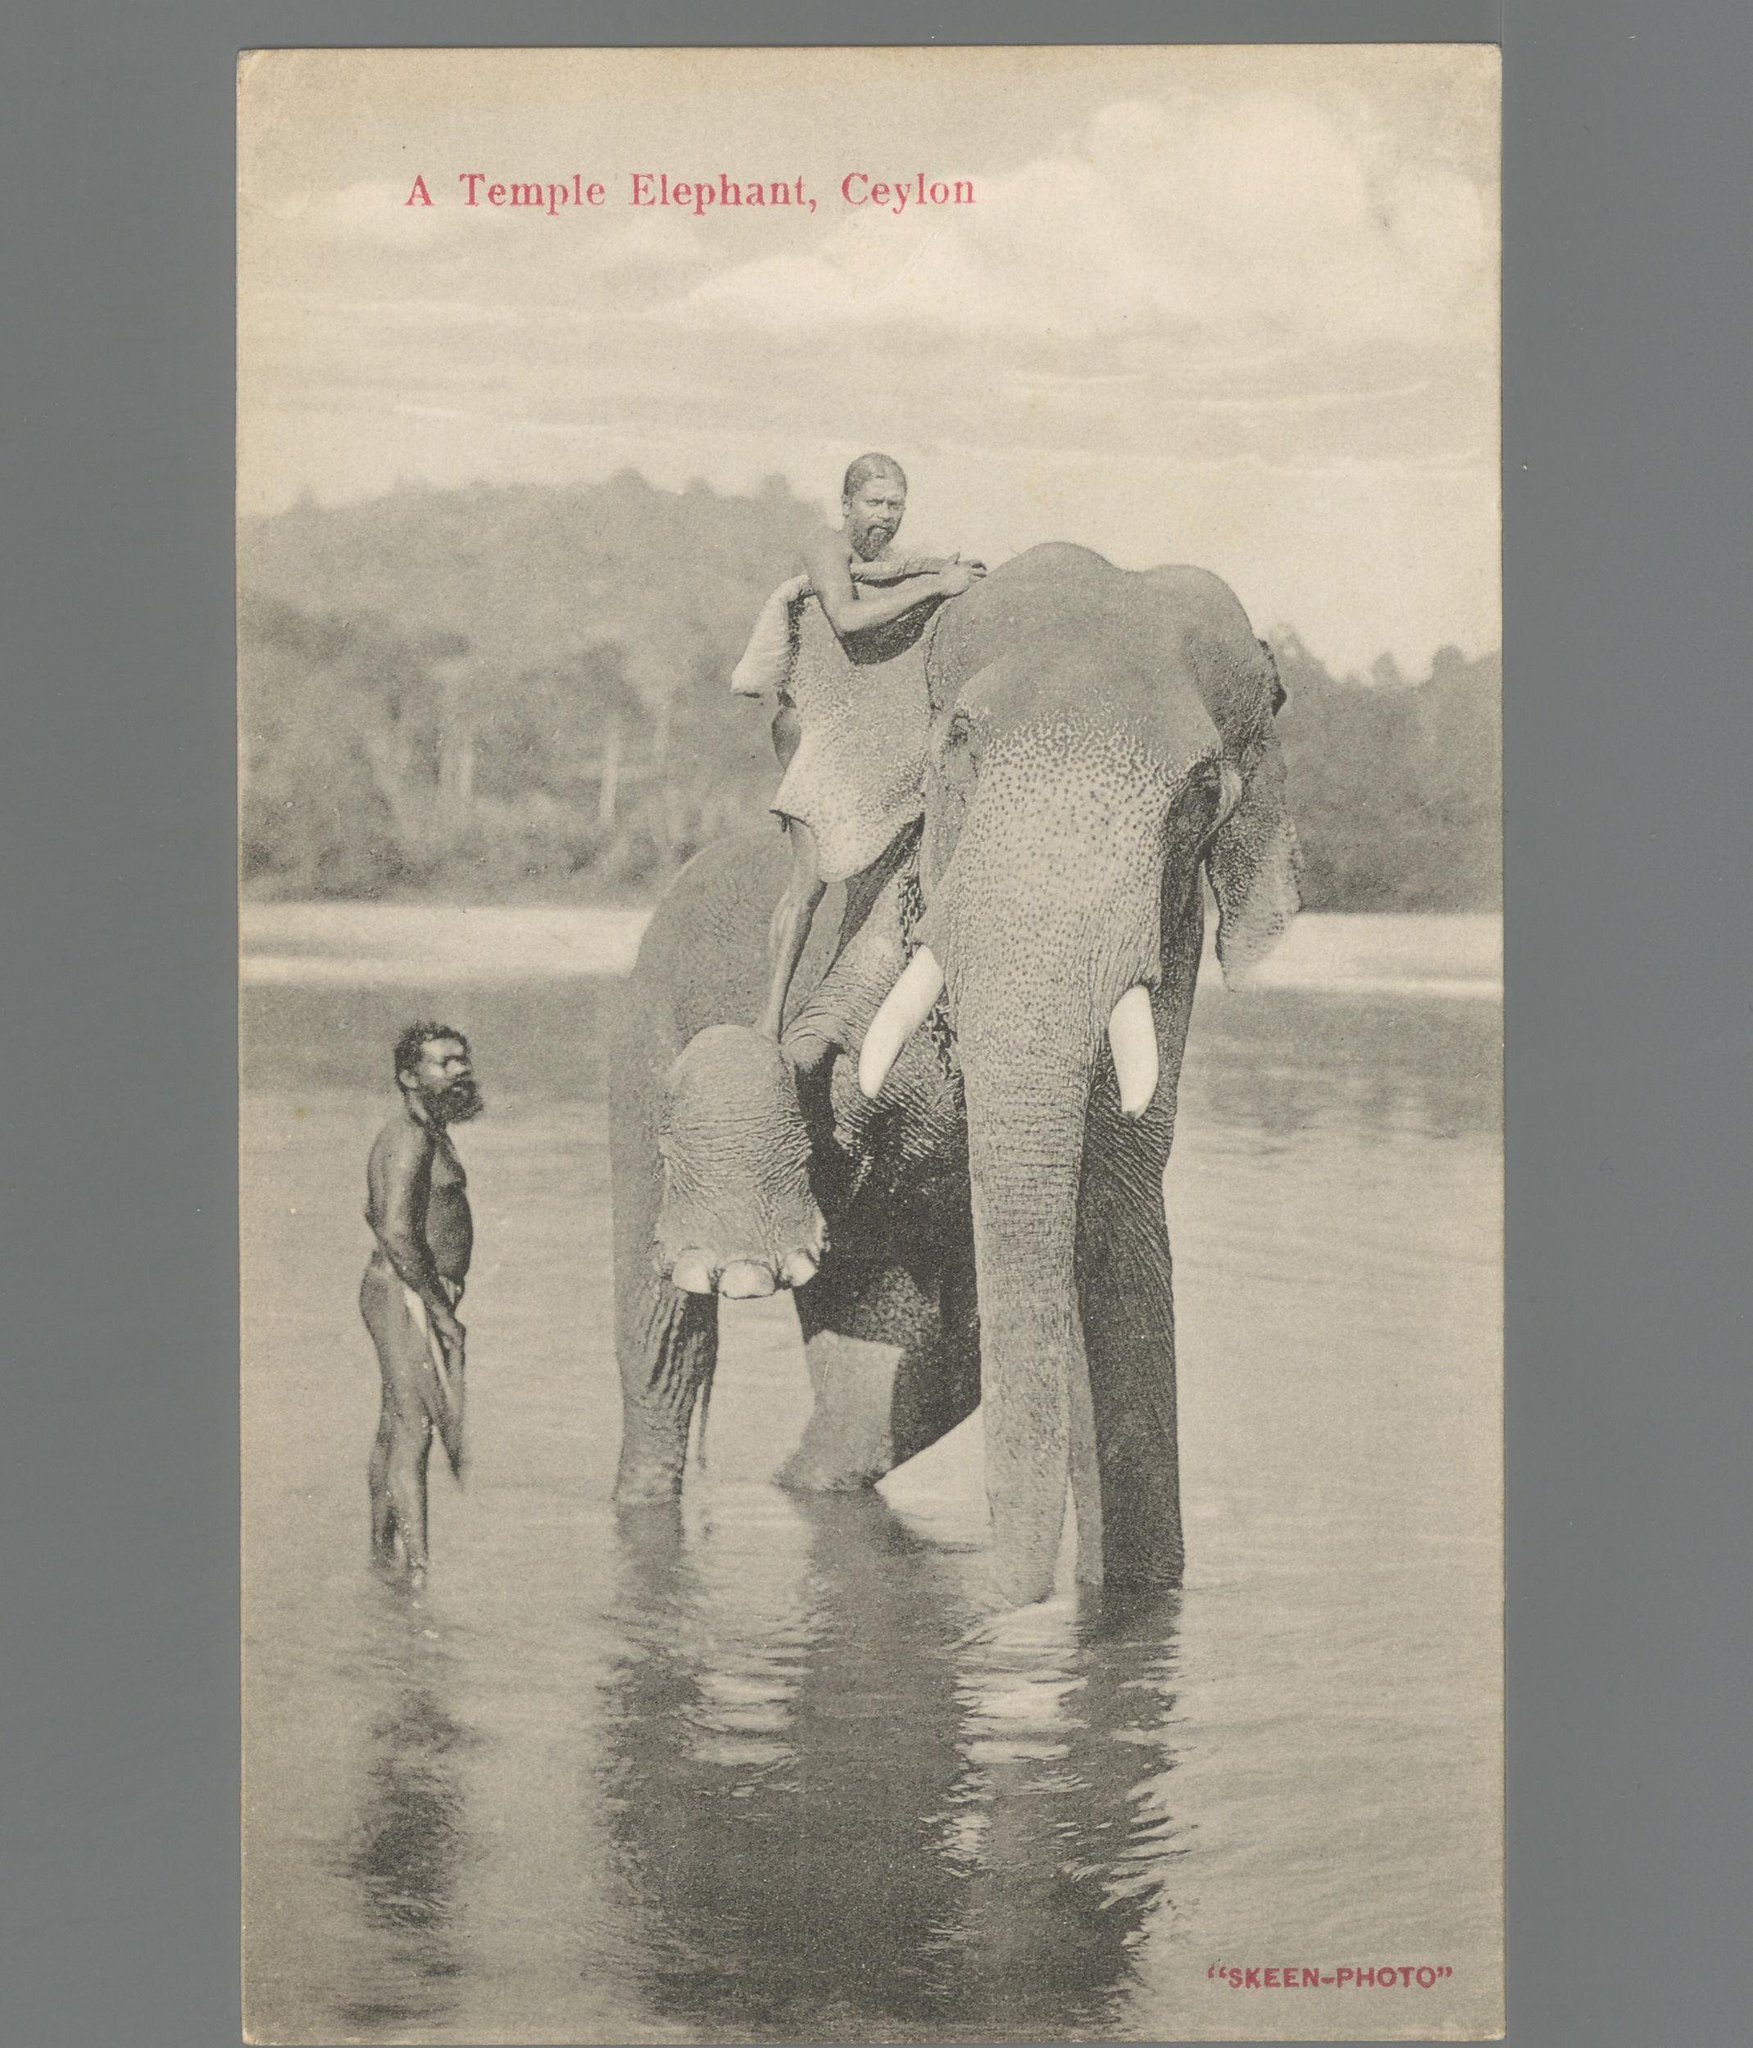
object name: ansichtkaart, prentbriefkaart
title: A Temple Elephant, Ceylon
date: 1902-1903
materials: cardboard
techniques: photograph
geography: colombo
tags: adult man ( + one person), trunked animals: elephant